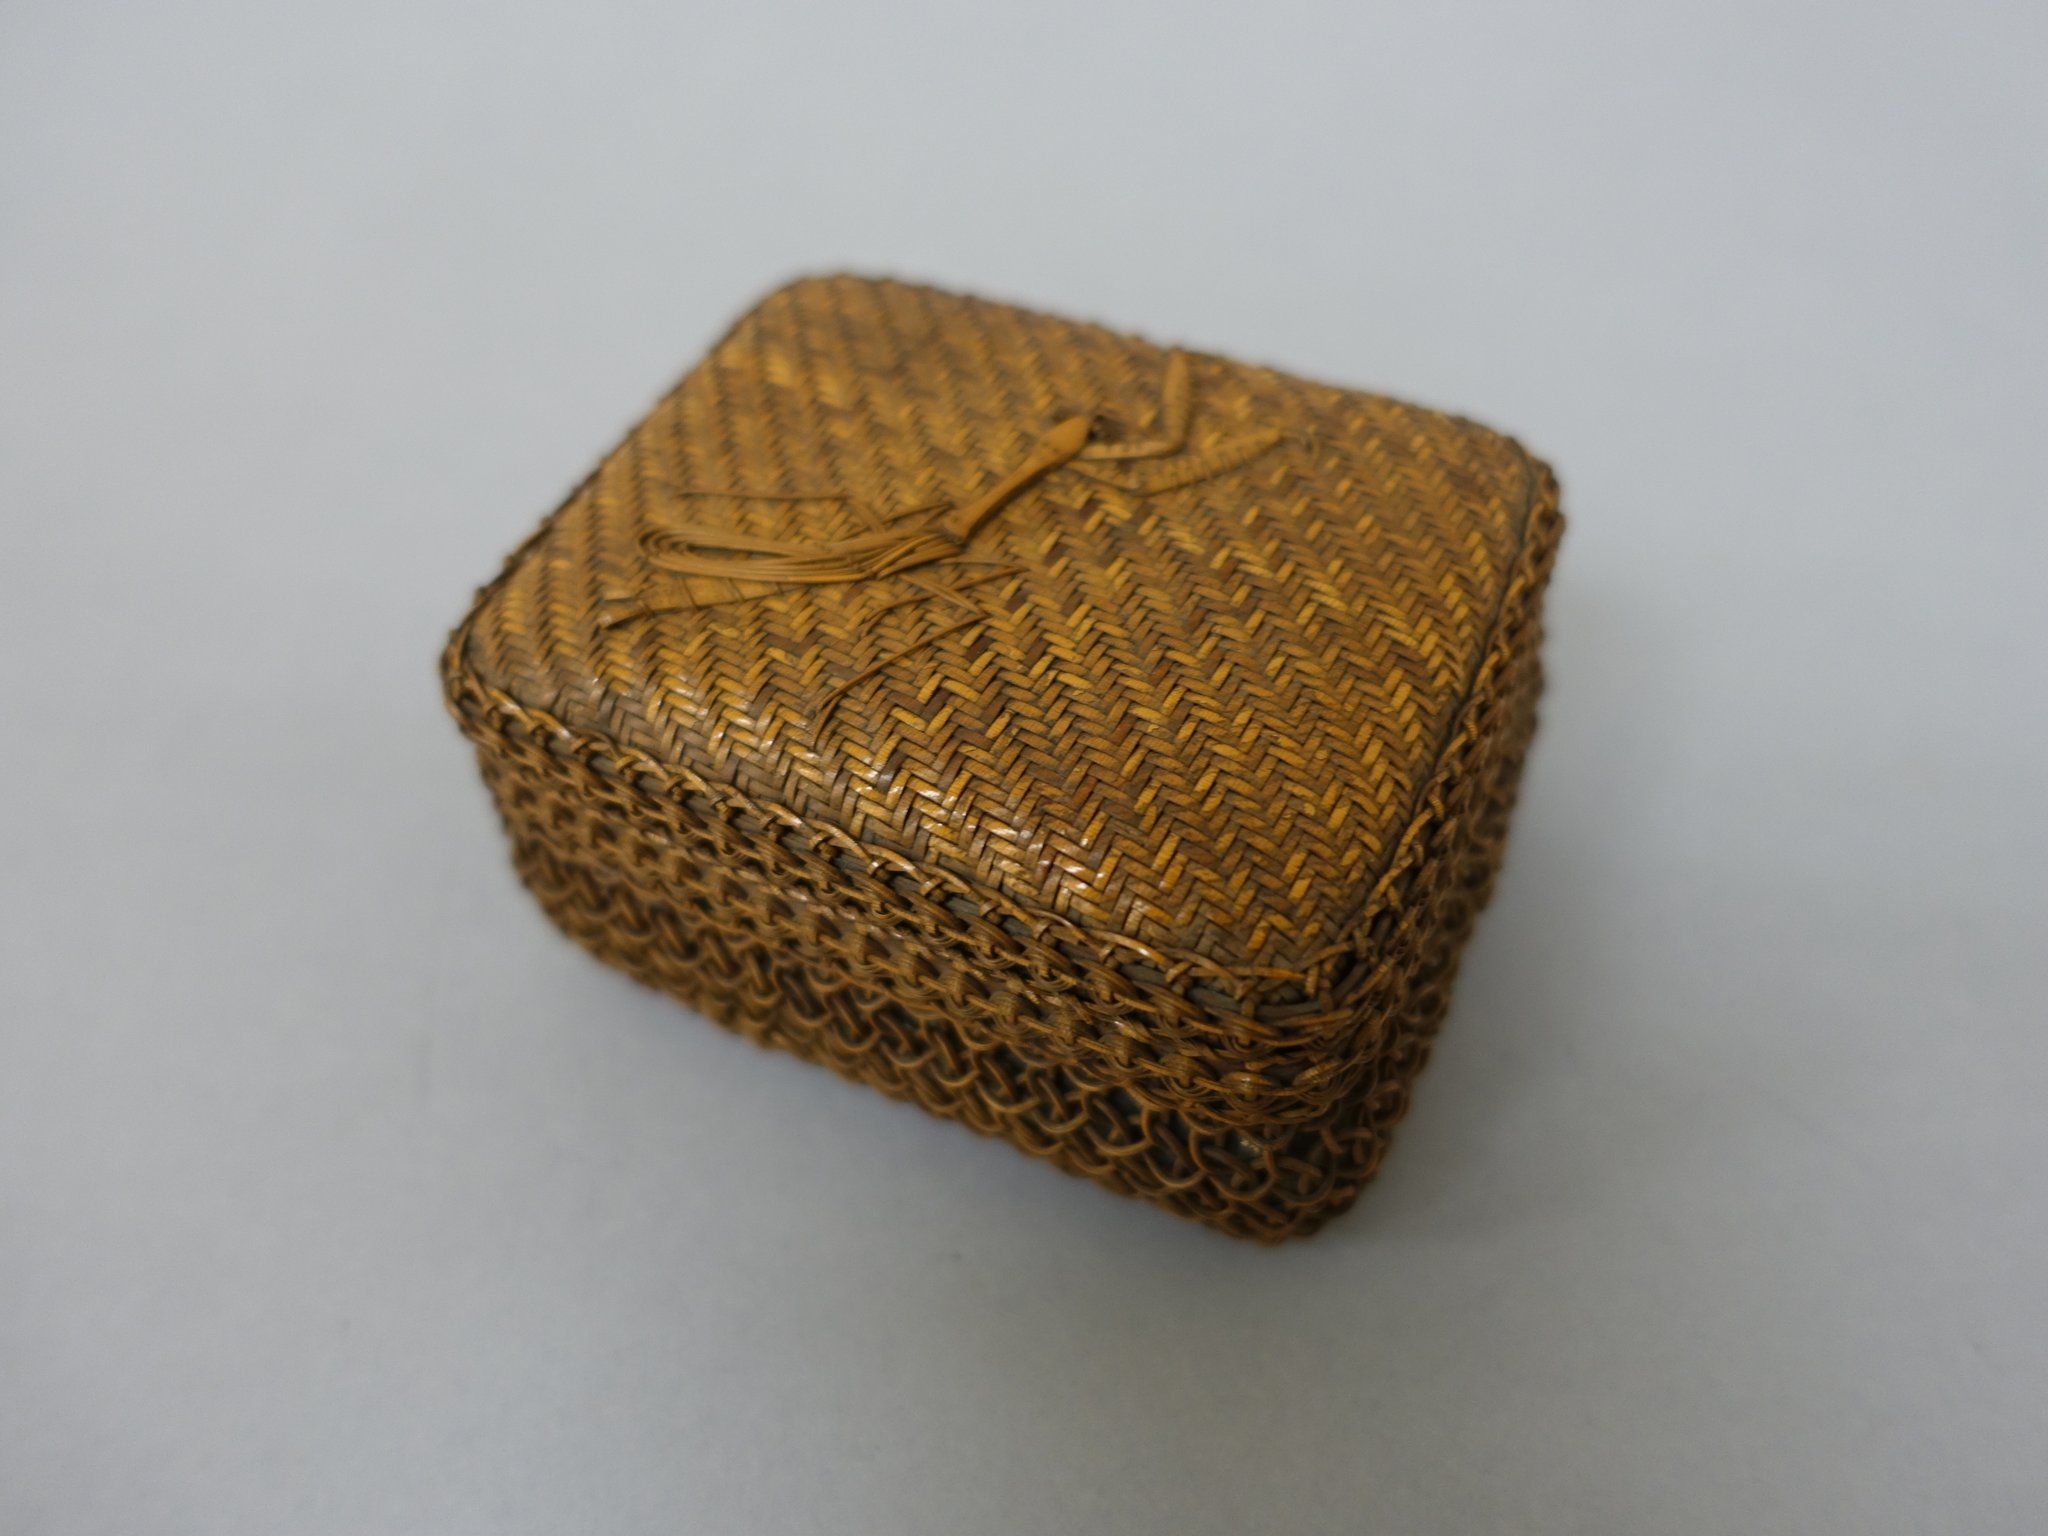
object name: box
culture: japanese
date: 1801-1900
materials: bamboo